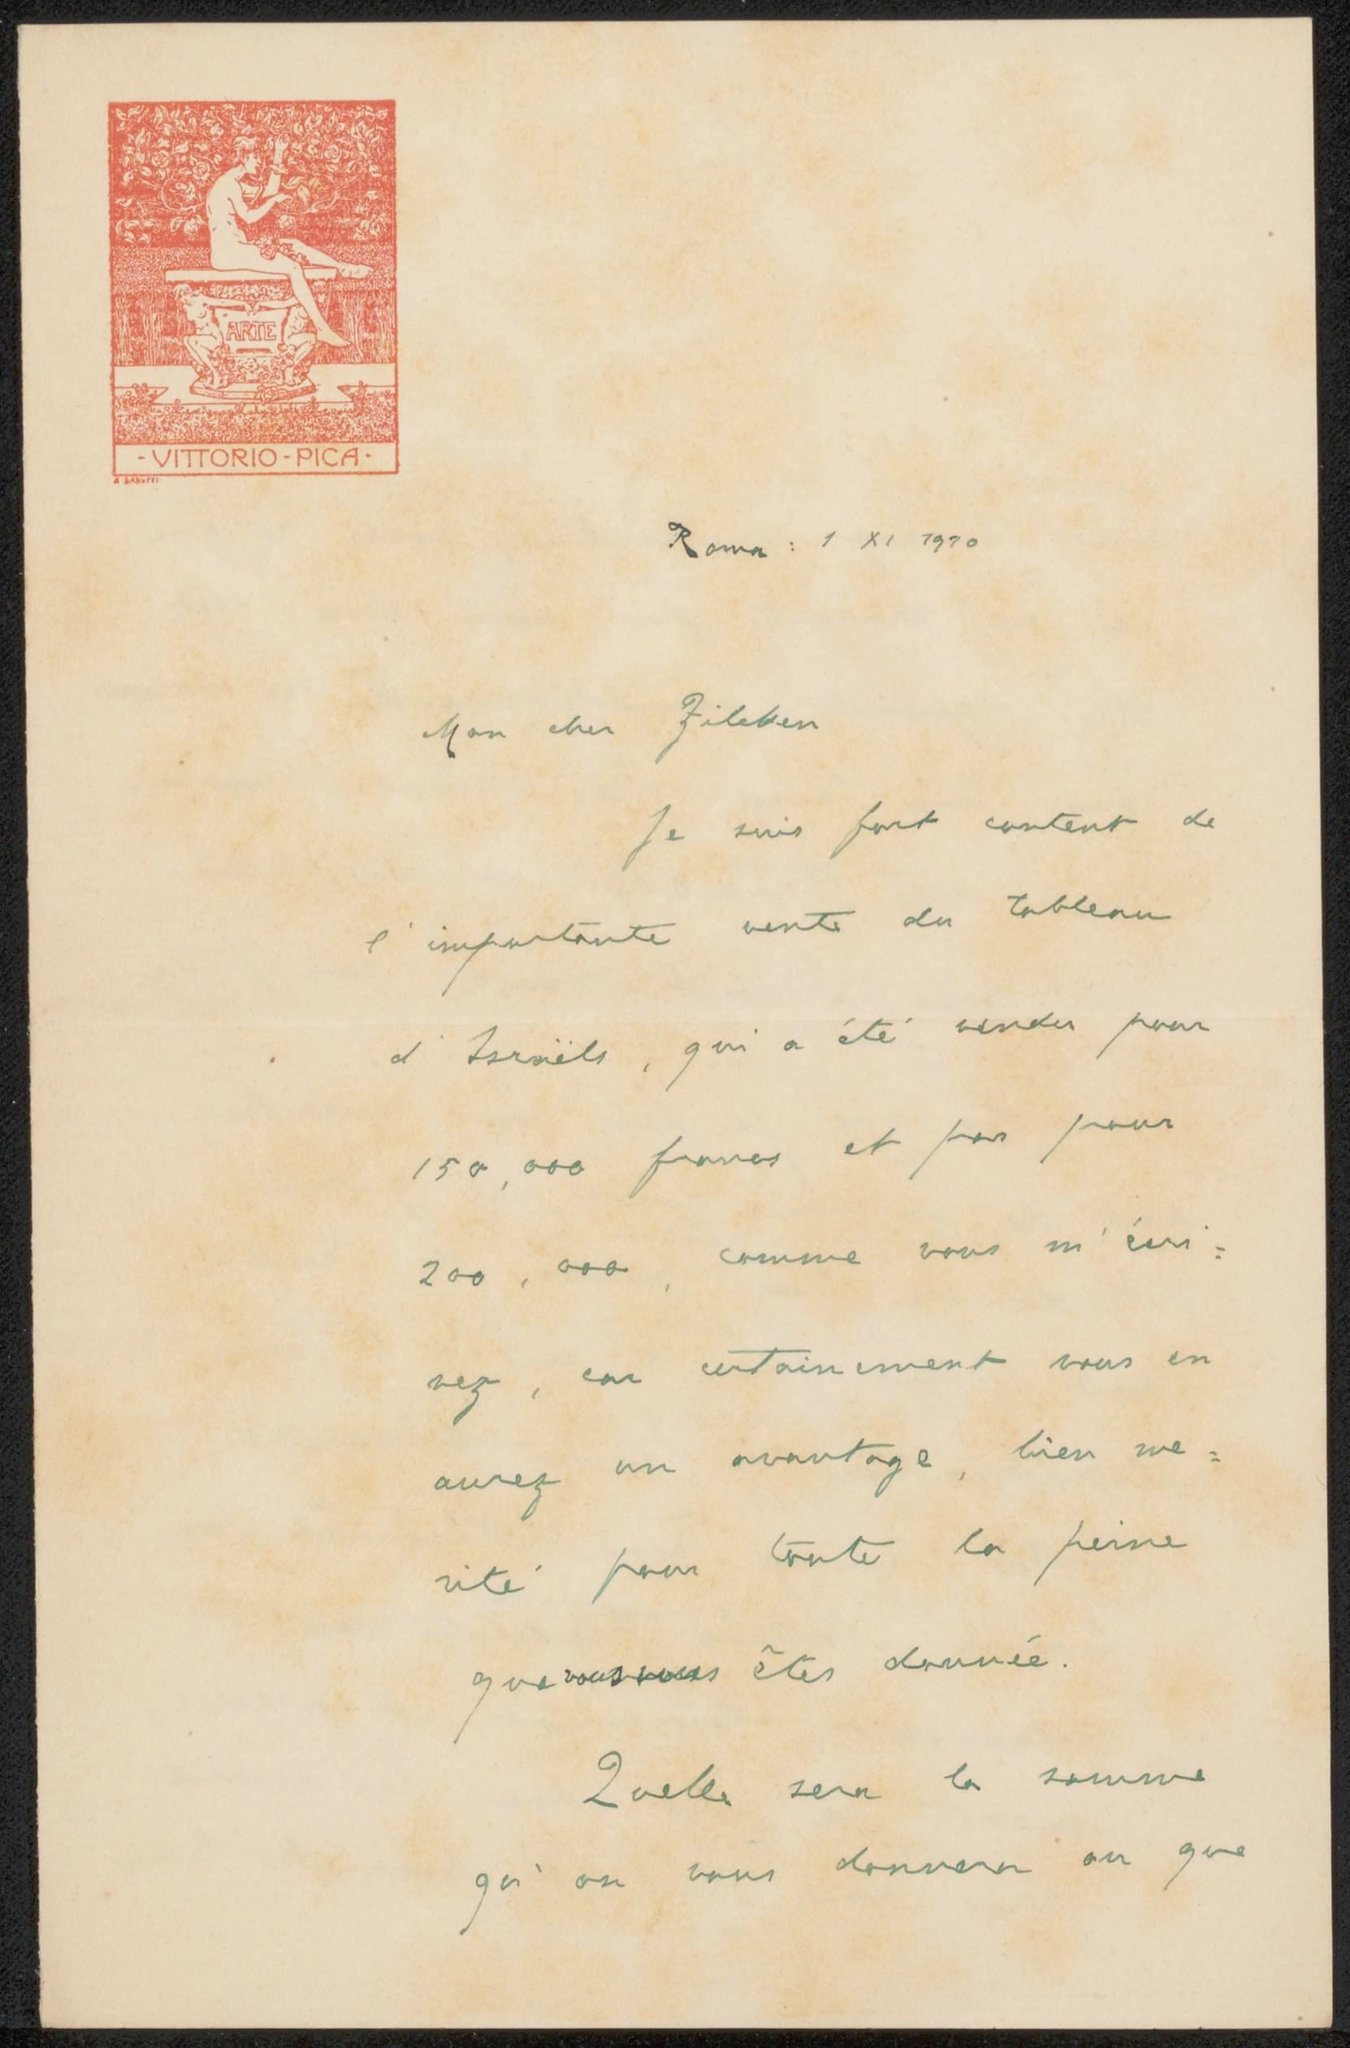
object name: letter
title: Brief aan Philip Zilcken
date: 1910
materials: ink, paper, pencil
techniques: pen, printing, writing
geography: rome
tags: print maker, jozef israëls, venice, politician, antonio fradeletto, painter, draughtsman, philip zilcken, painting (including book-illumination, miniature-painting), exhibition ~ art, money, printed matter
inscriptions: collector's mark: ‘RPK’, watermark